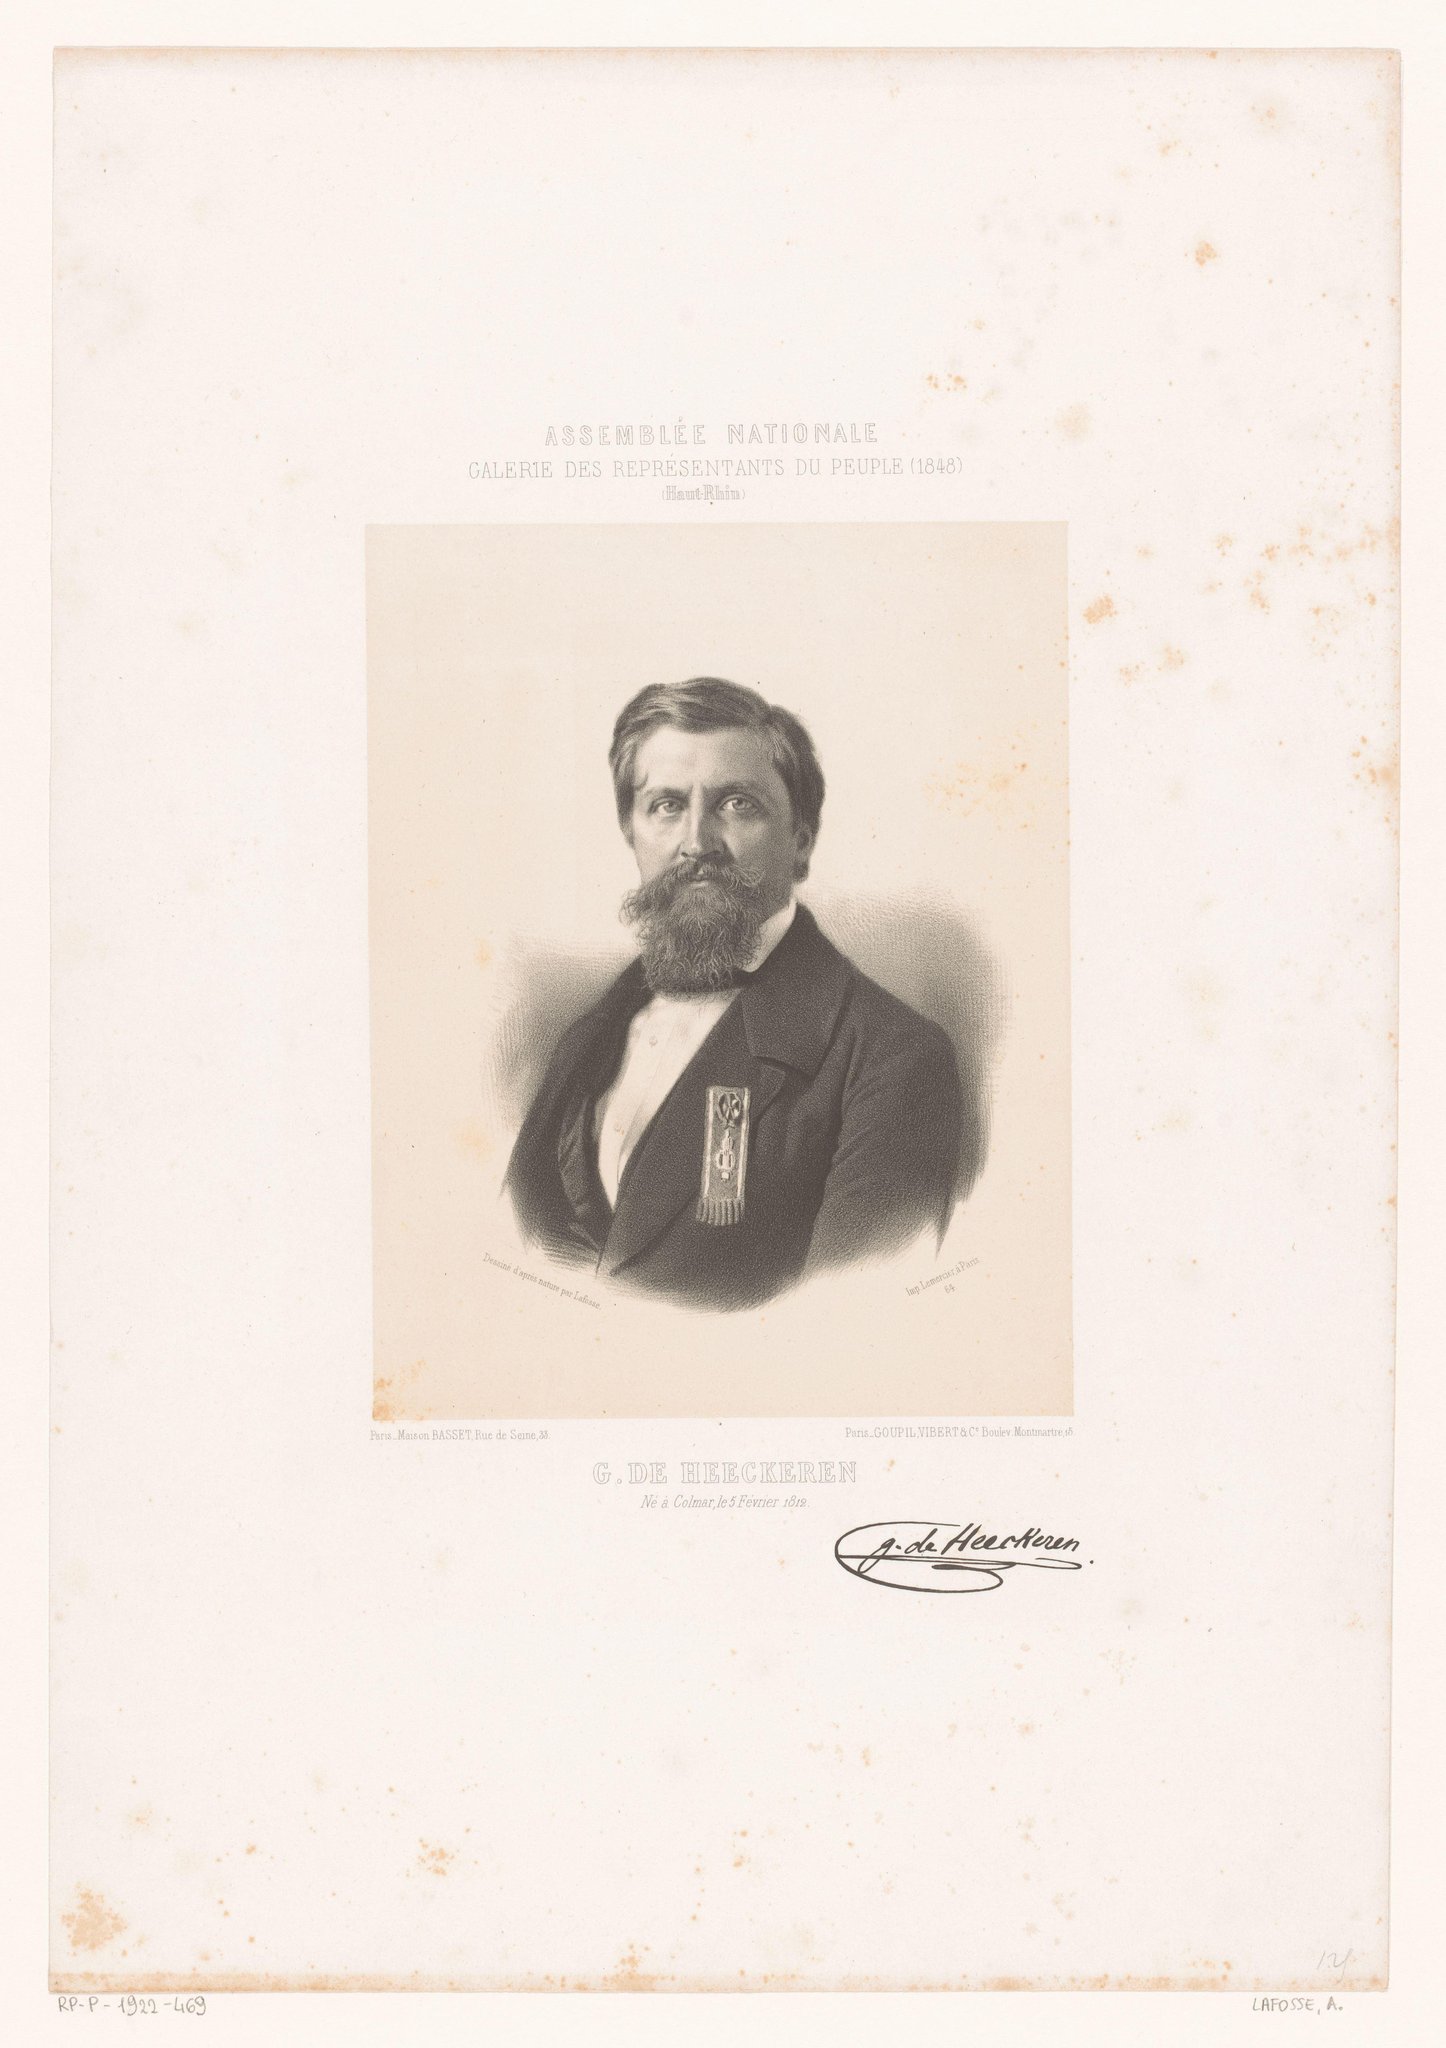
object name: print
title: Leden van de Nationale Vergadering: volksvertegenwoordigers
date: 1848-1849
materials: paper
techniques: tone lithography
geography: paris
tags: politician, historical persons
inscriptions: collector's mark: Lugt 2233